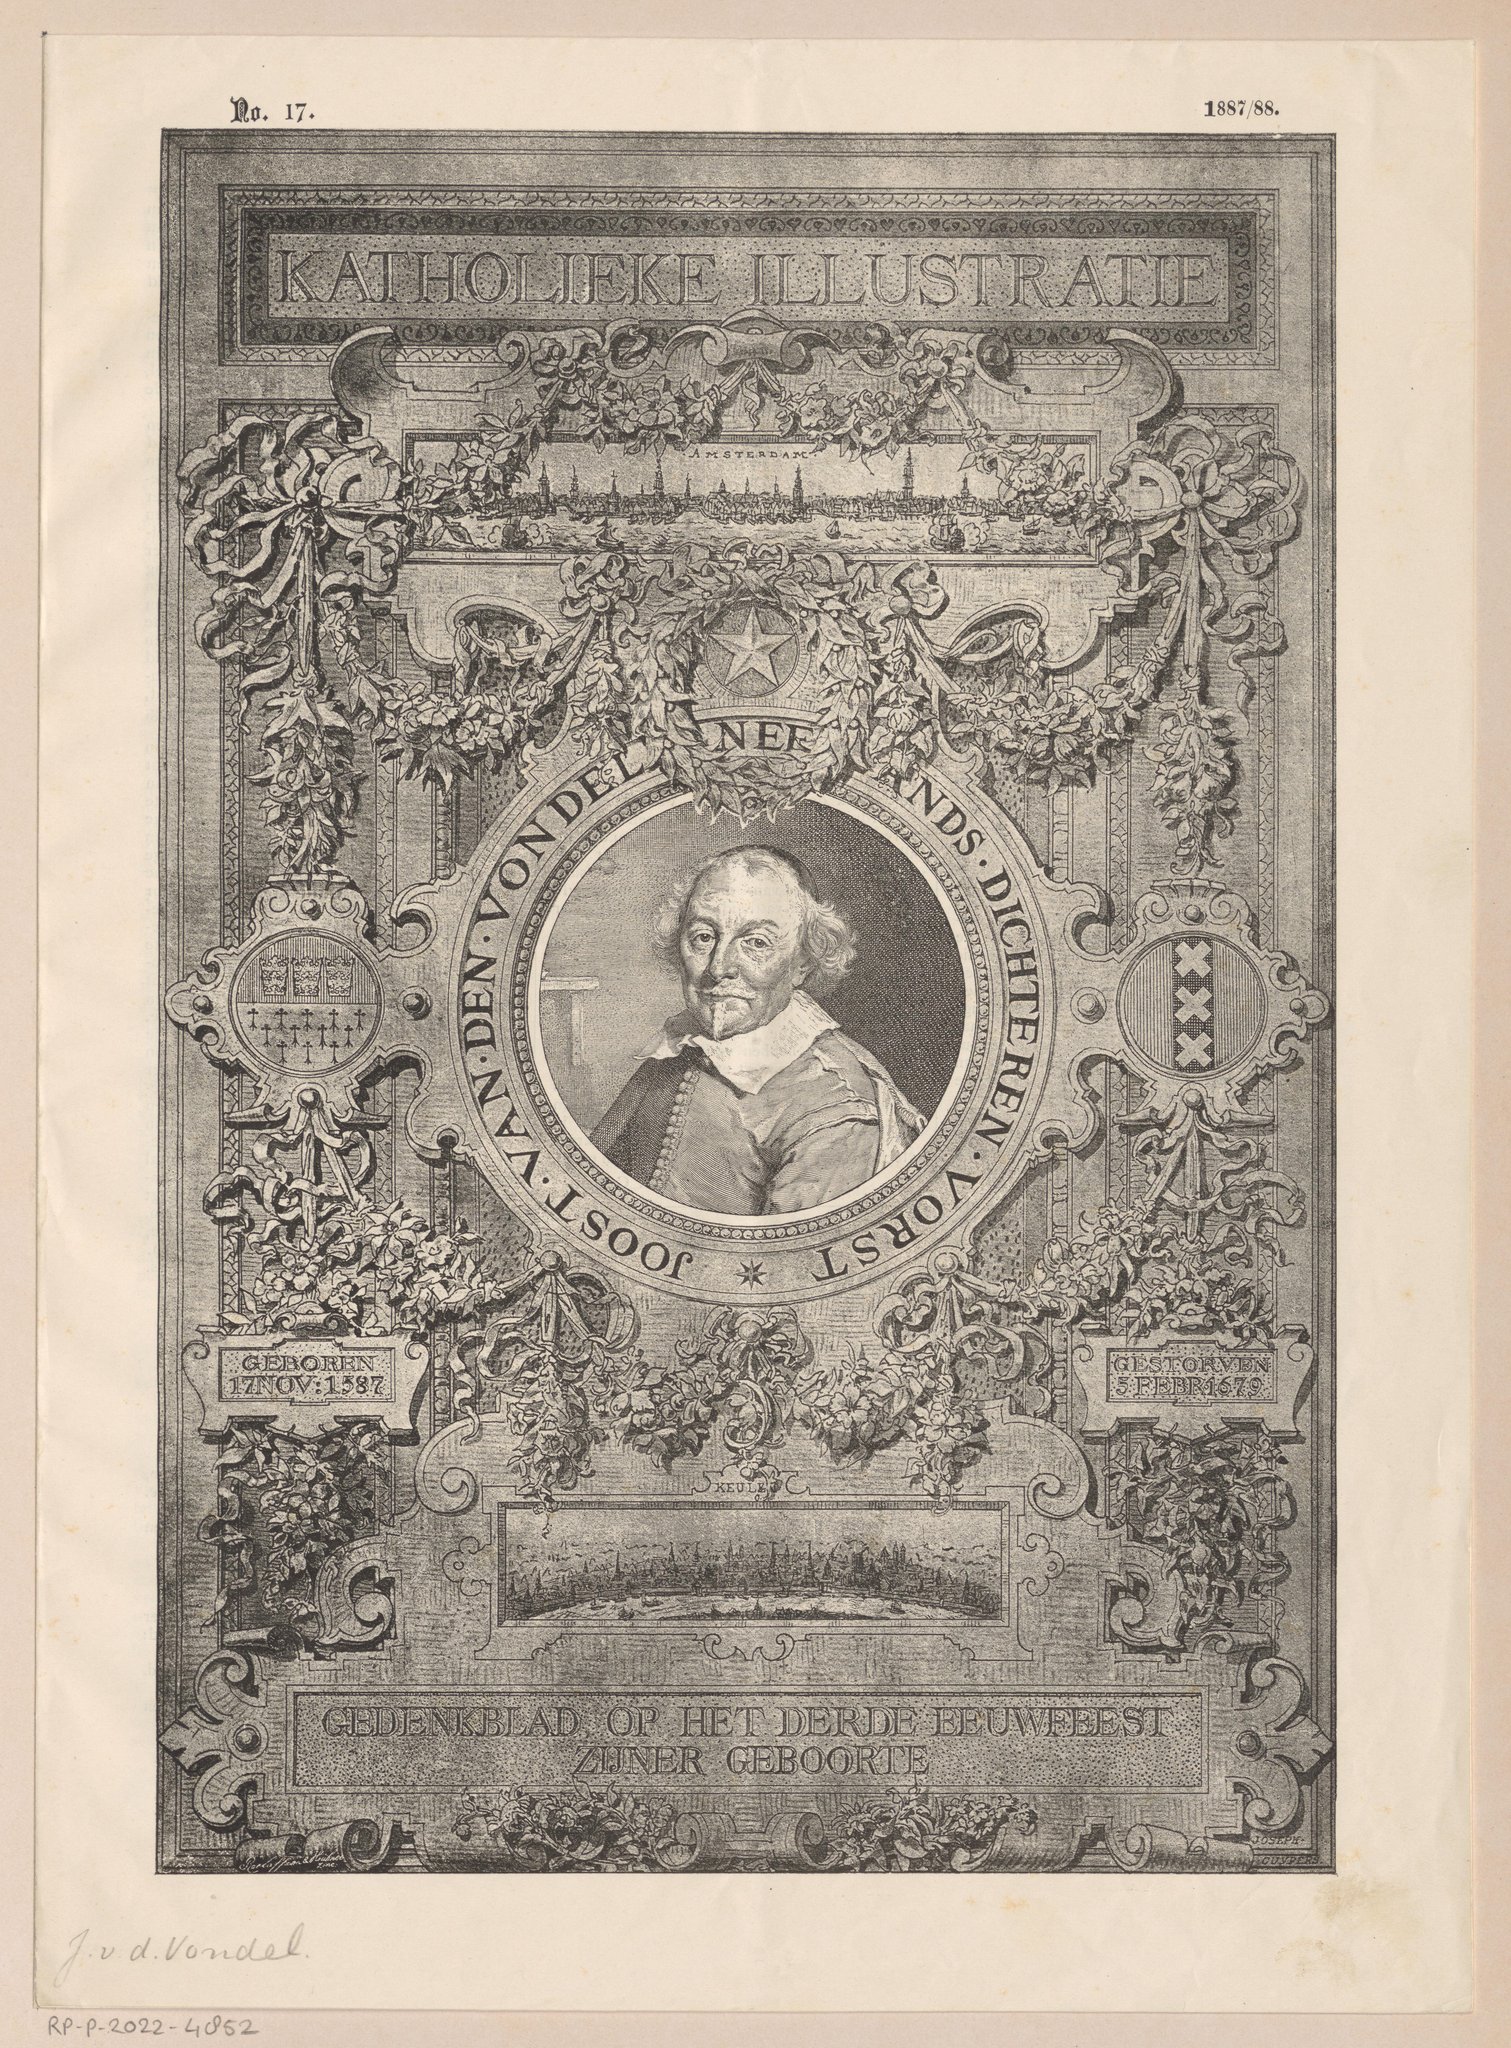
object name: photomechanical print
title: Portret van Joost van den Vondel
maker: joseph theodorus johannes cuypers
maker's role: sculptor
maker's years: 1861-1949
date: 1887-1888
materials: paper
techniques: letterpress printing, line block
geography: netherlands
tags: amsterdam, joost van den vondel, city-view, and landscape with man-made constructions, ornaments ~ art, historical persons, portrait of a writer, writer, poet, author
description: Prent uit: De Katholieke Illustratie (1887-1888), nr. 17.